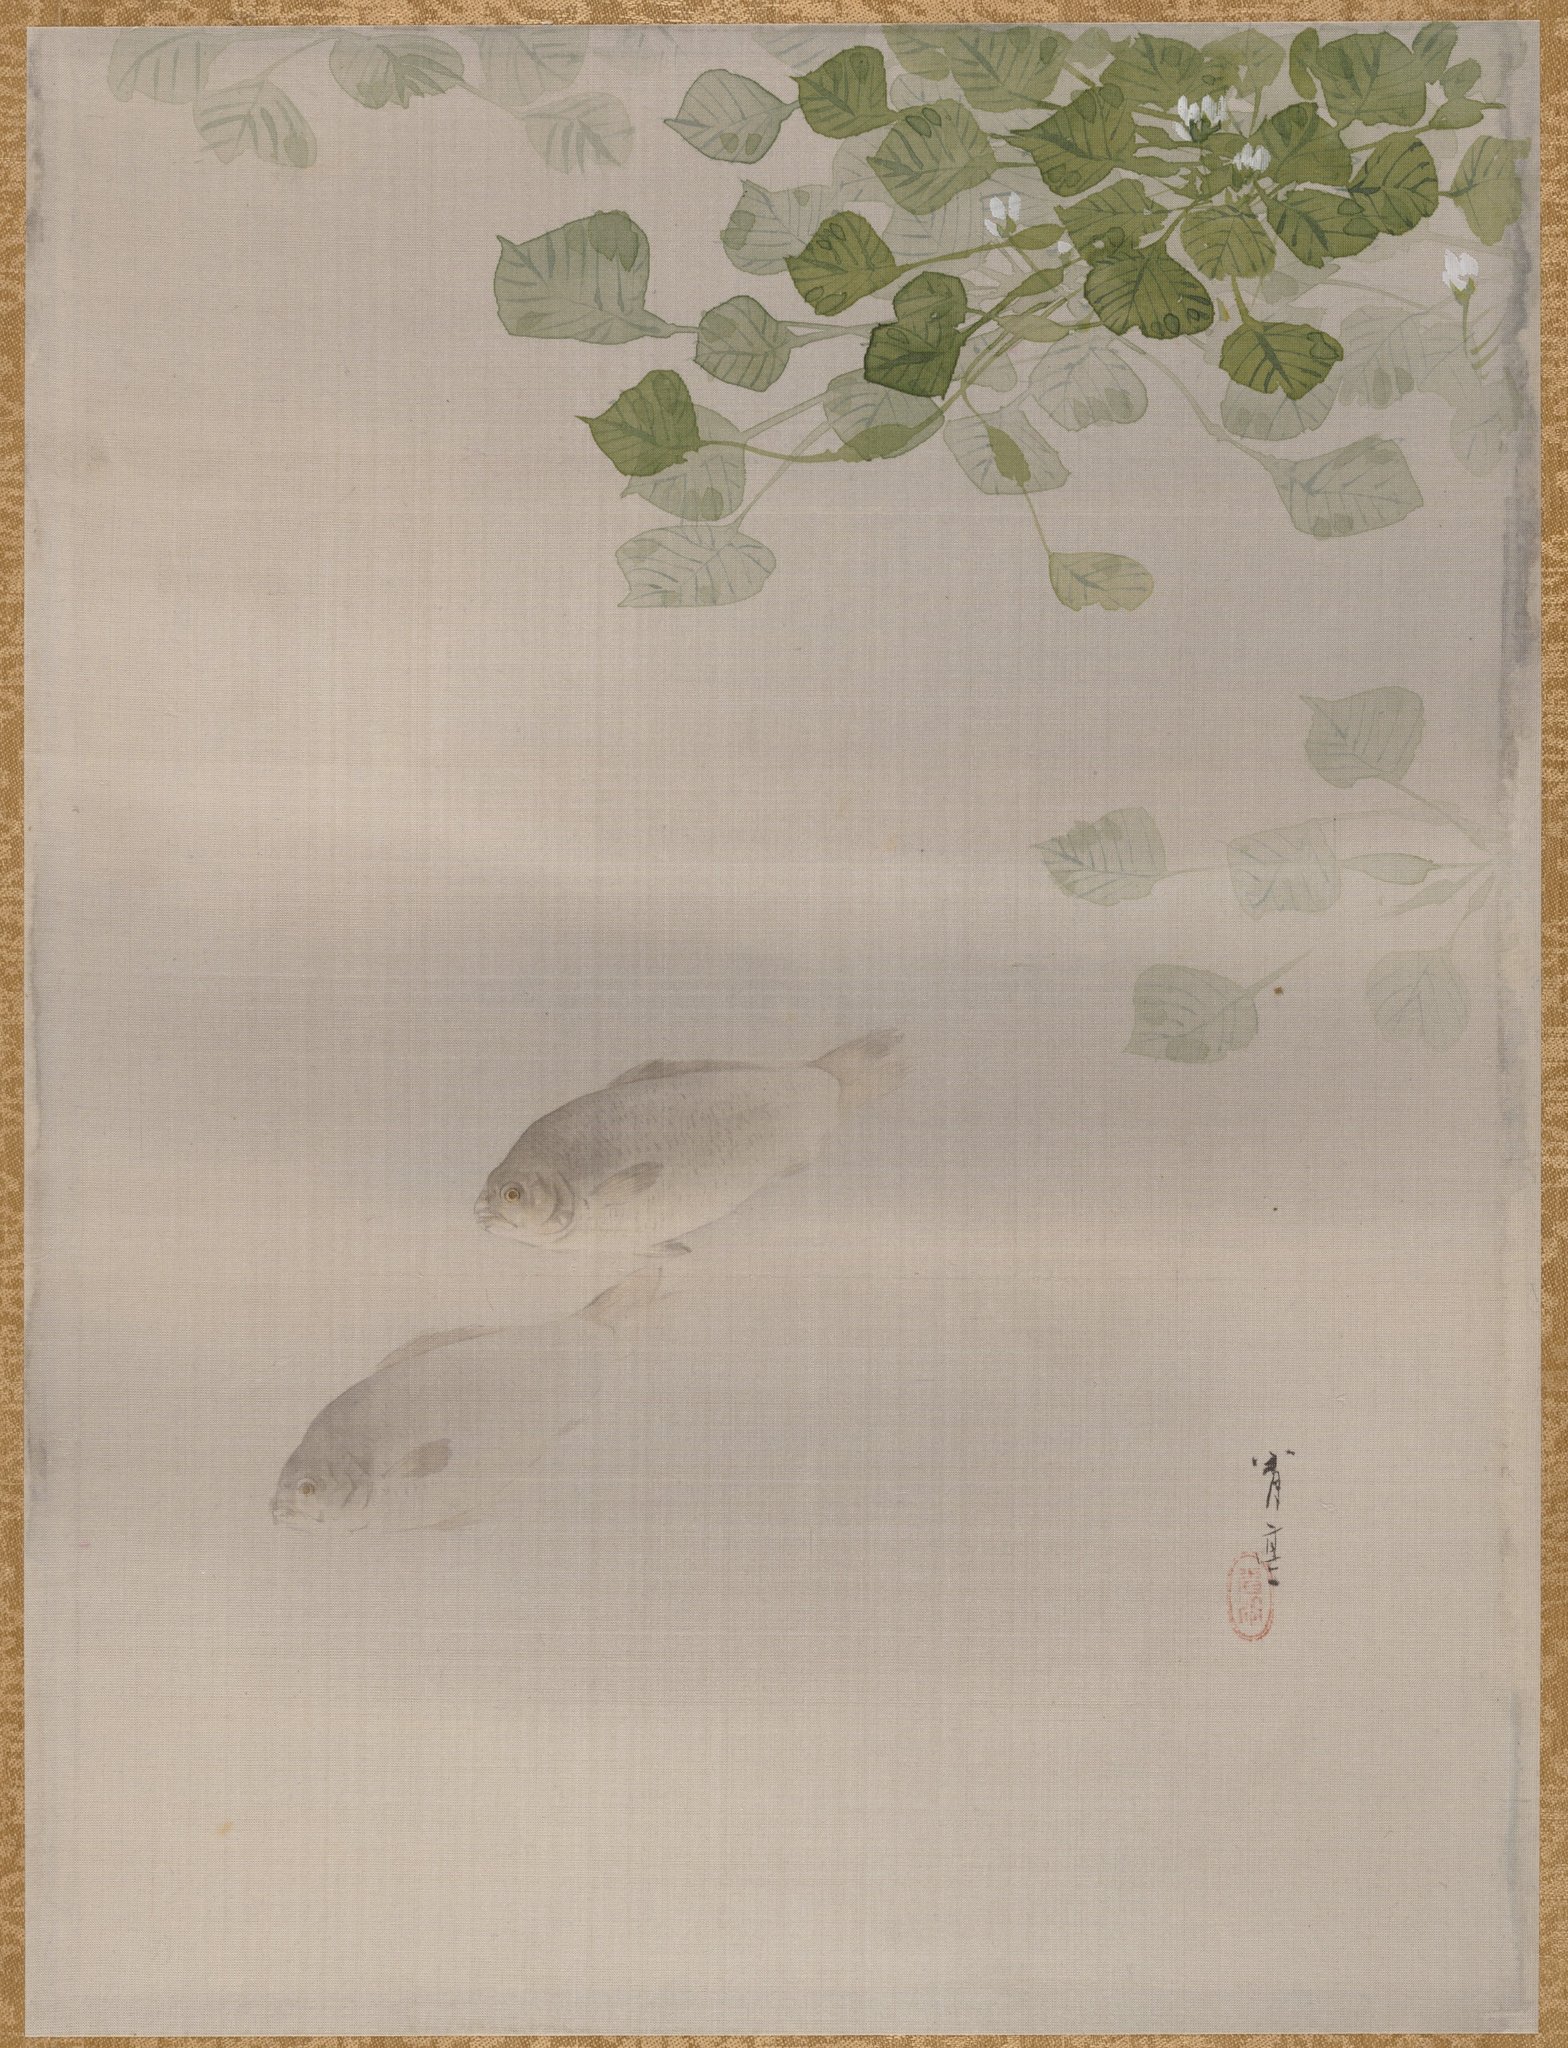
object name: album leaf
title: Fishes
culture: japanese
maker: watanabe seitei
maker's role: artist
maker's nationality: japanese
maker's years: 1851-1918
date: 1887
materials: ink, silk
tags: fish